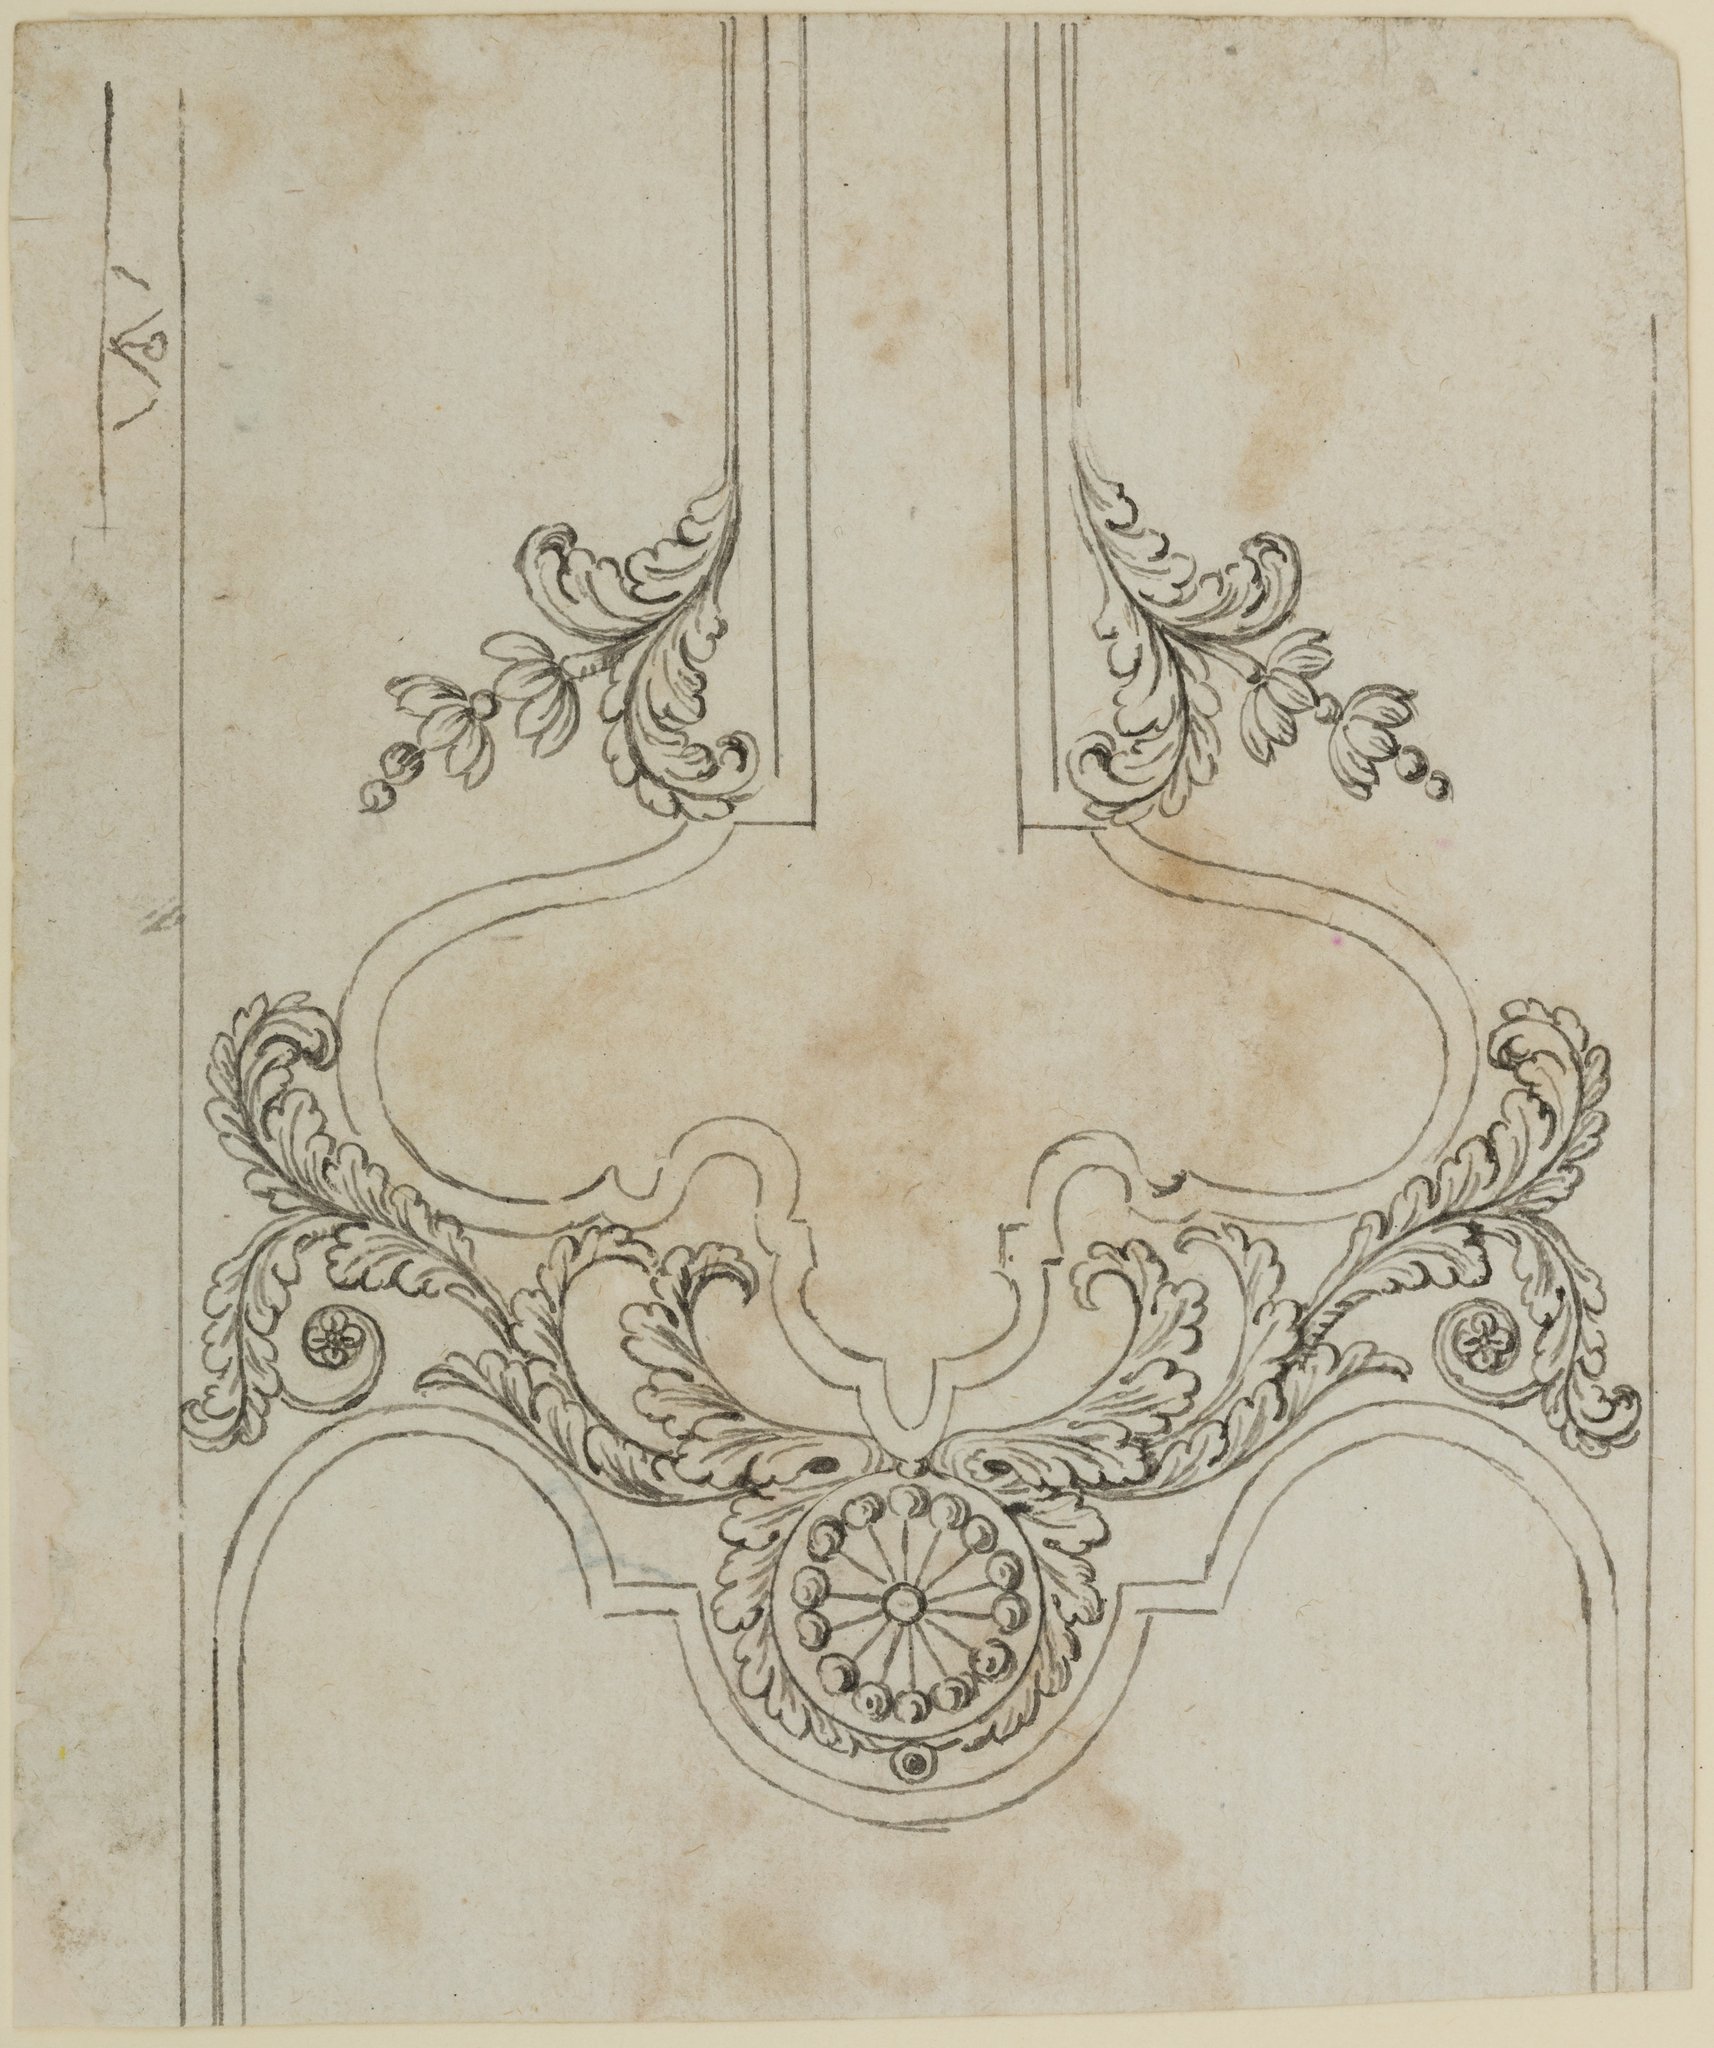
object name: drawing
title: Design for the Decoration of the Surround of the Barrel Flat and Rear Sight of a Firearm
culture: french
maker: nicolas noël boutet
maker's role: designer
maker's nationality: french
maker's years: 1761-1833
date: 1797-1805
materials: ink, paper, pencil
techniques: wash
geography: france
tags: ornament